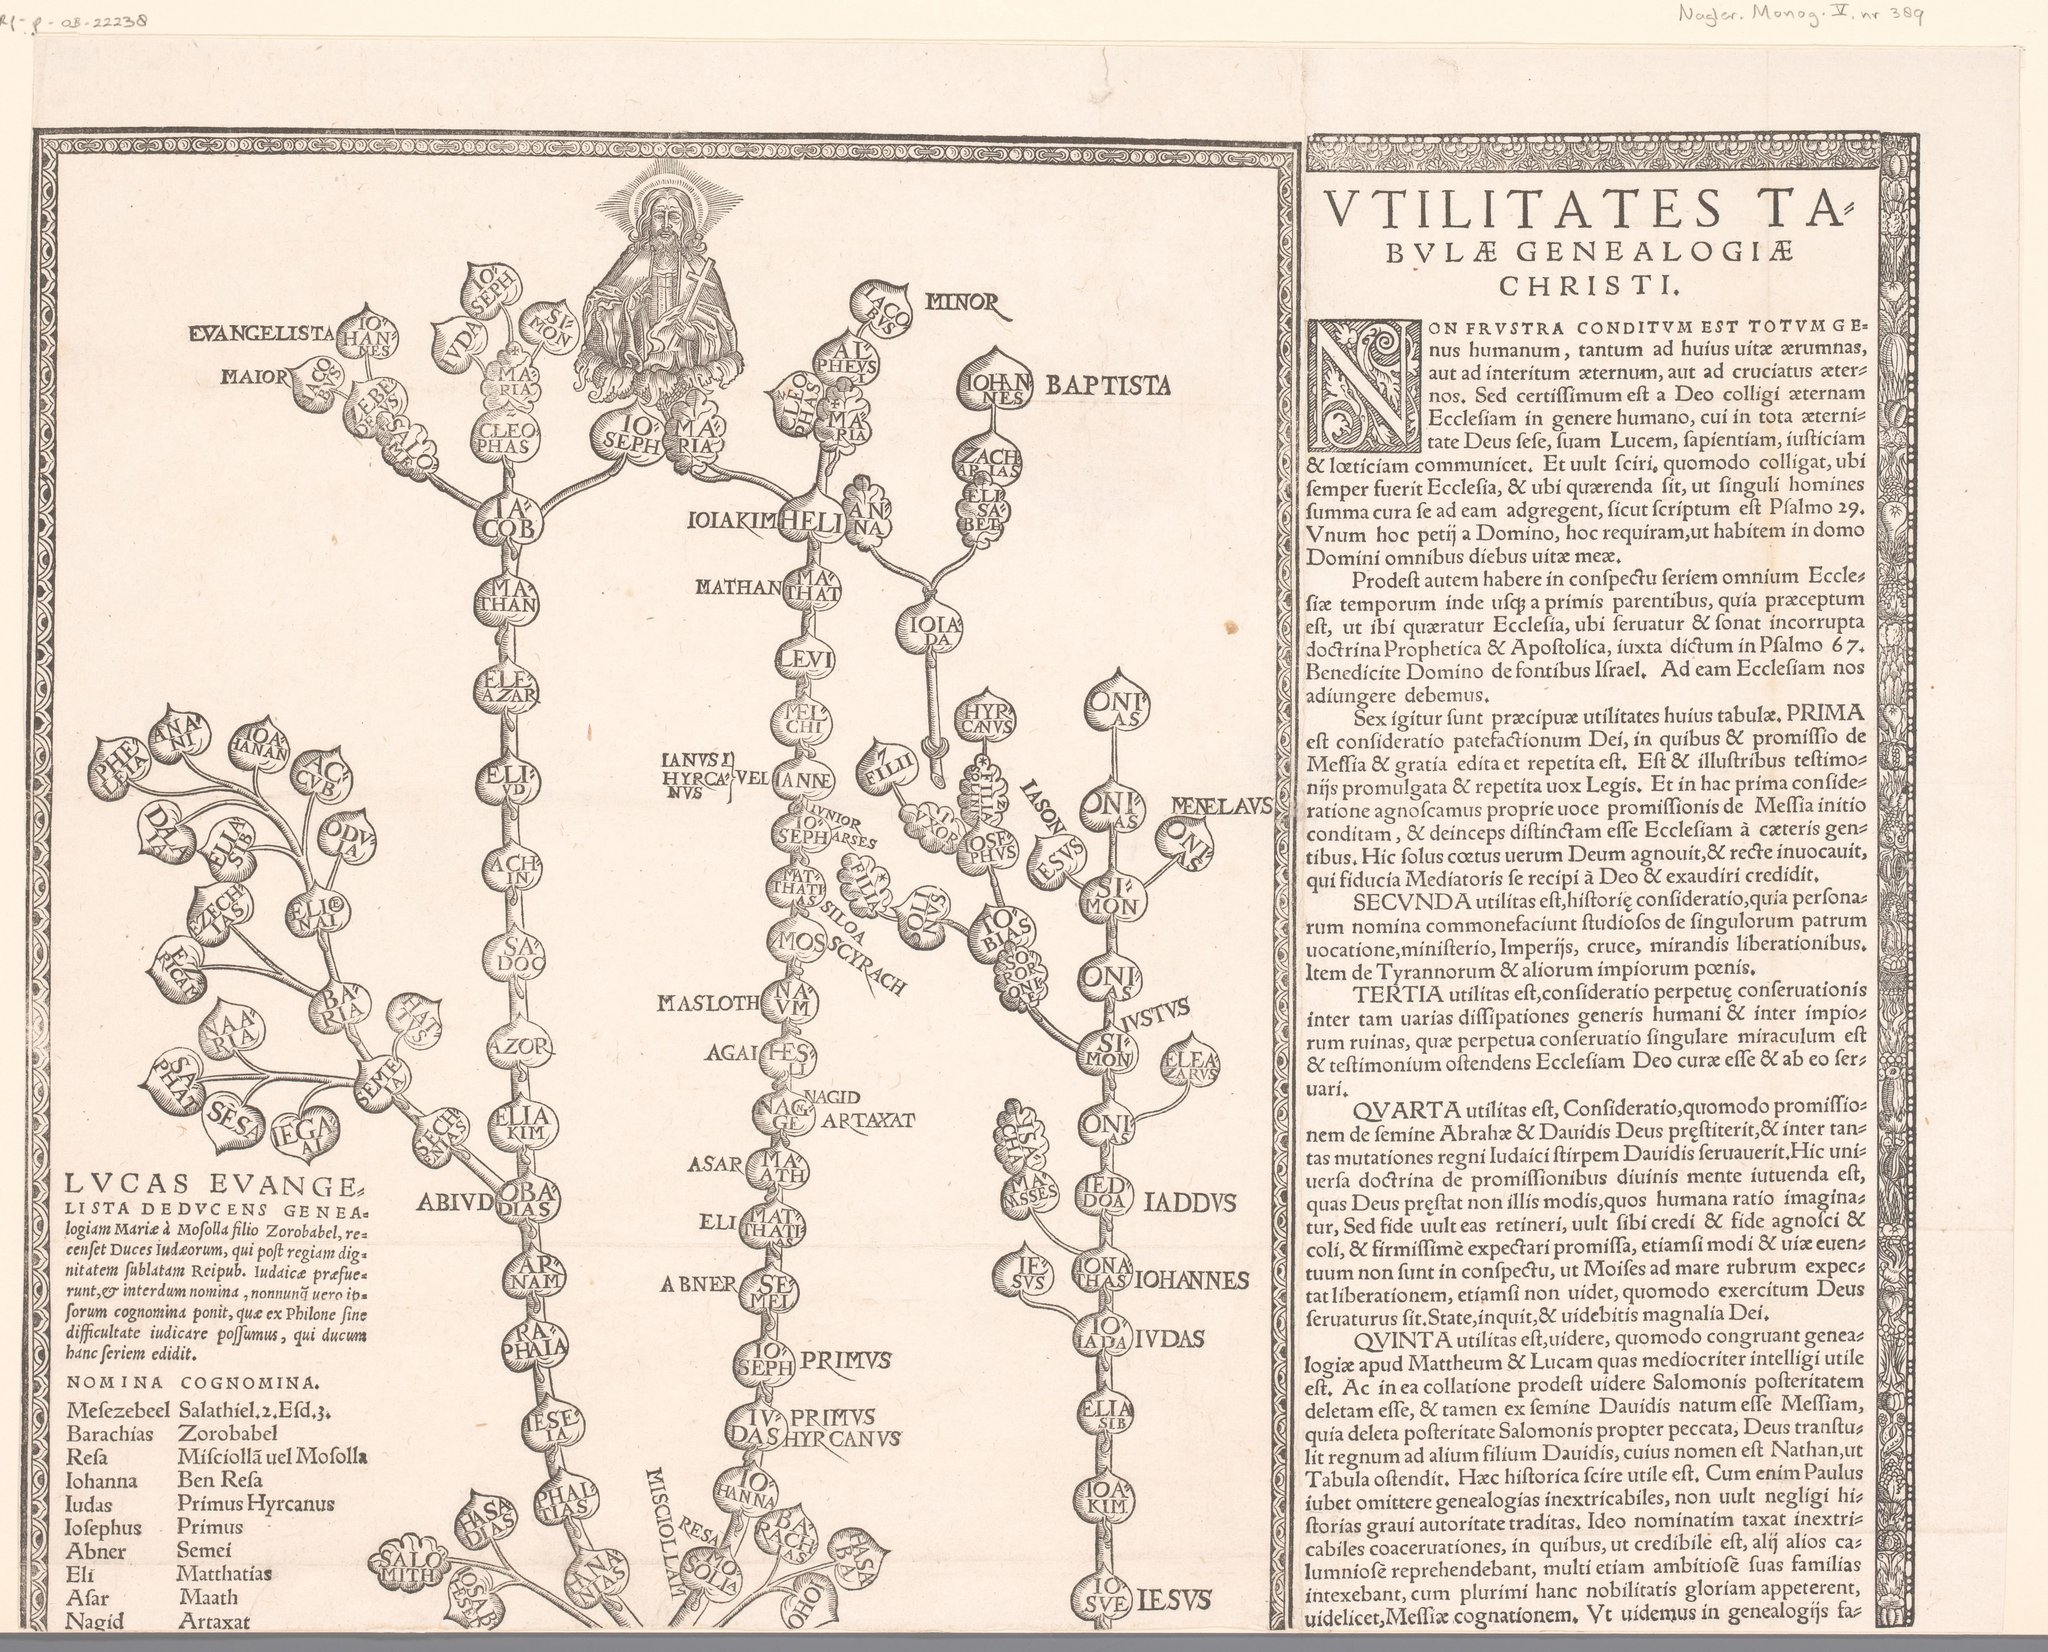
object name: print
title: Stamboom van Christus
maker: tillmann stella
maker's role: print maker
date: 1555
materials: paper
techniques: letterpress printing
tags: family lineage, pedigree, genealogical tree or table, christ